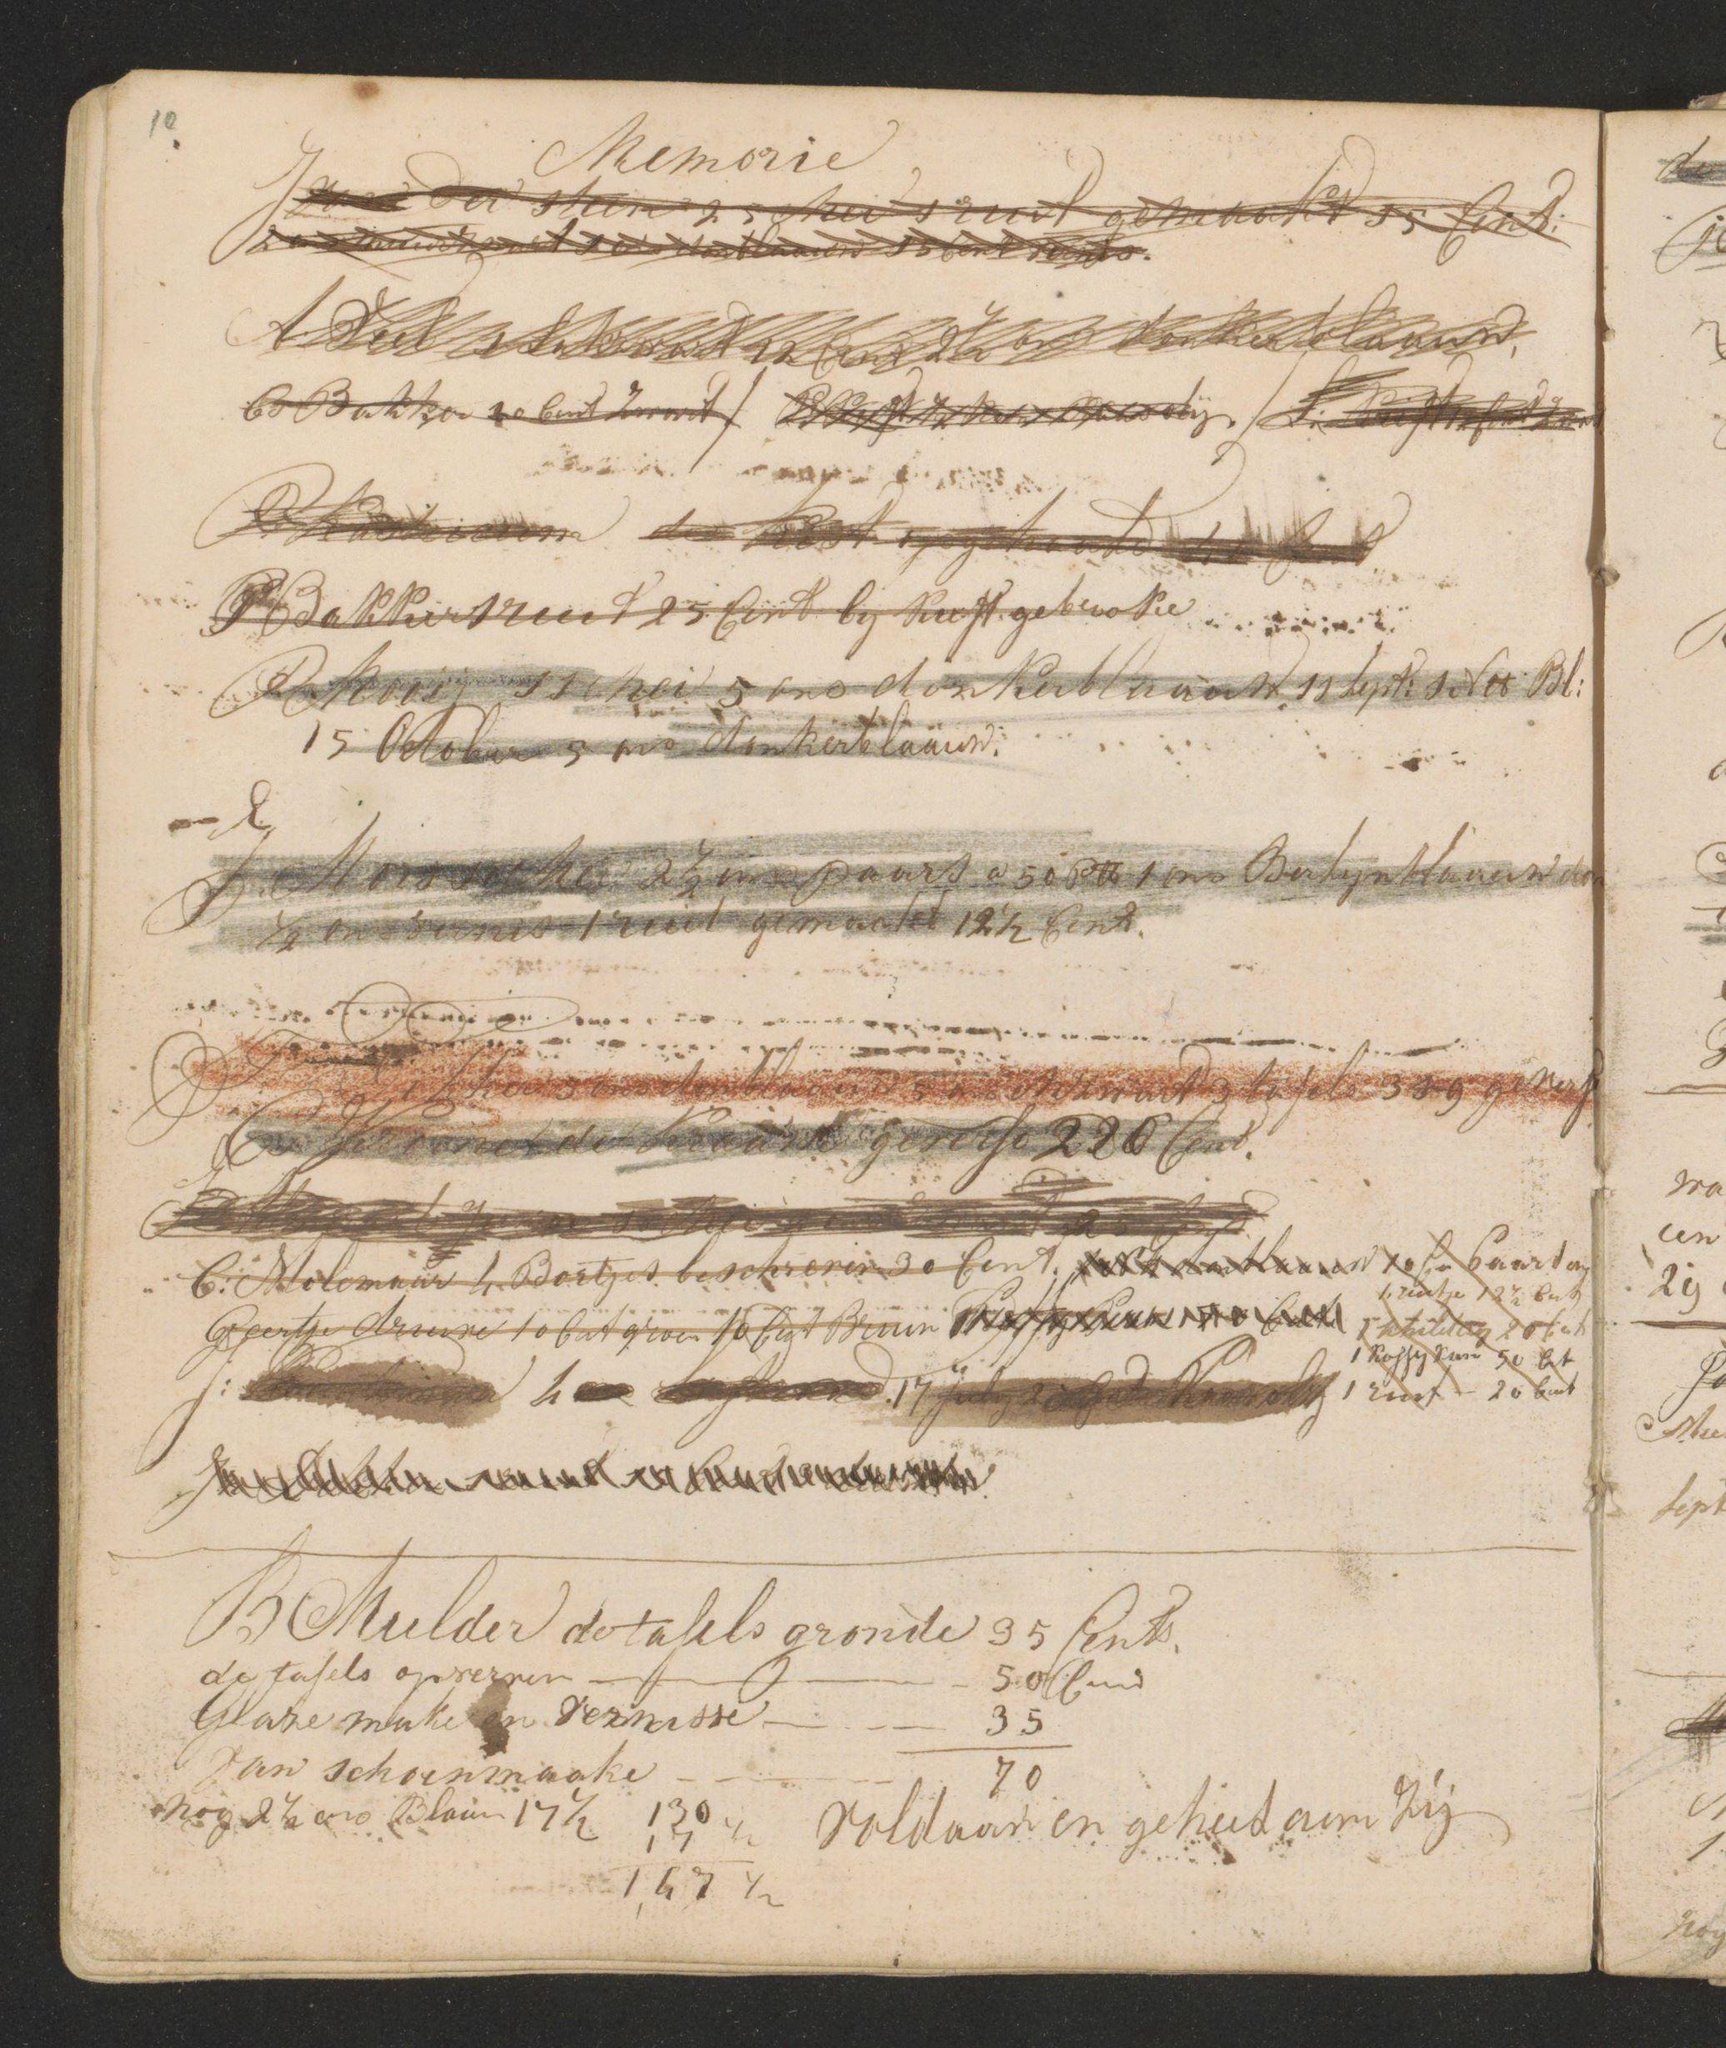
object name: sketchbook leaf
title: Kasboekaantekeningen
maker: Anonymous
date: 1840-1860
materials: ink, paper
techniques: pen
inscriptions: annotation: ‘Memorie ... aan zij’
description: Kasboek van een schilder met notities van aangeschafte materialen. Bladzijde 10 uit een schetsboek met 96 bladzijden.